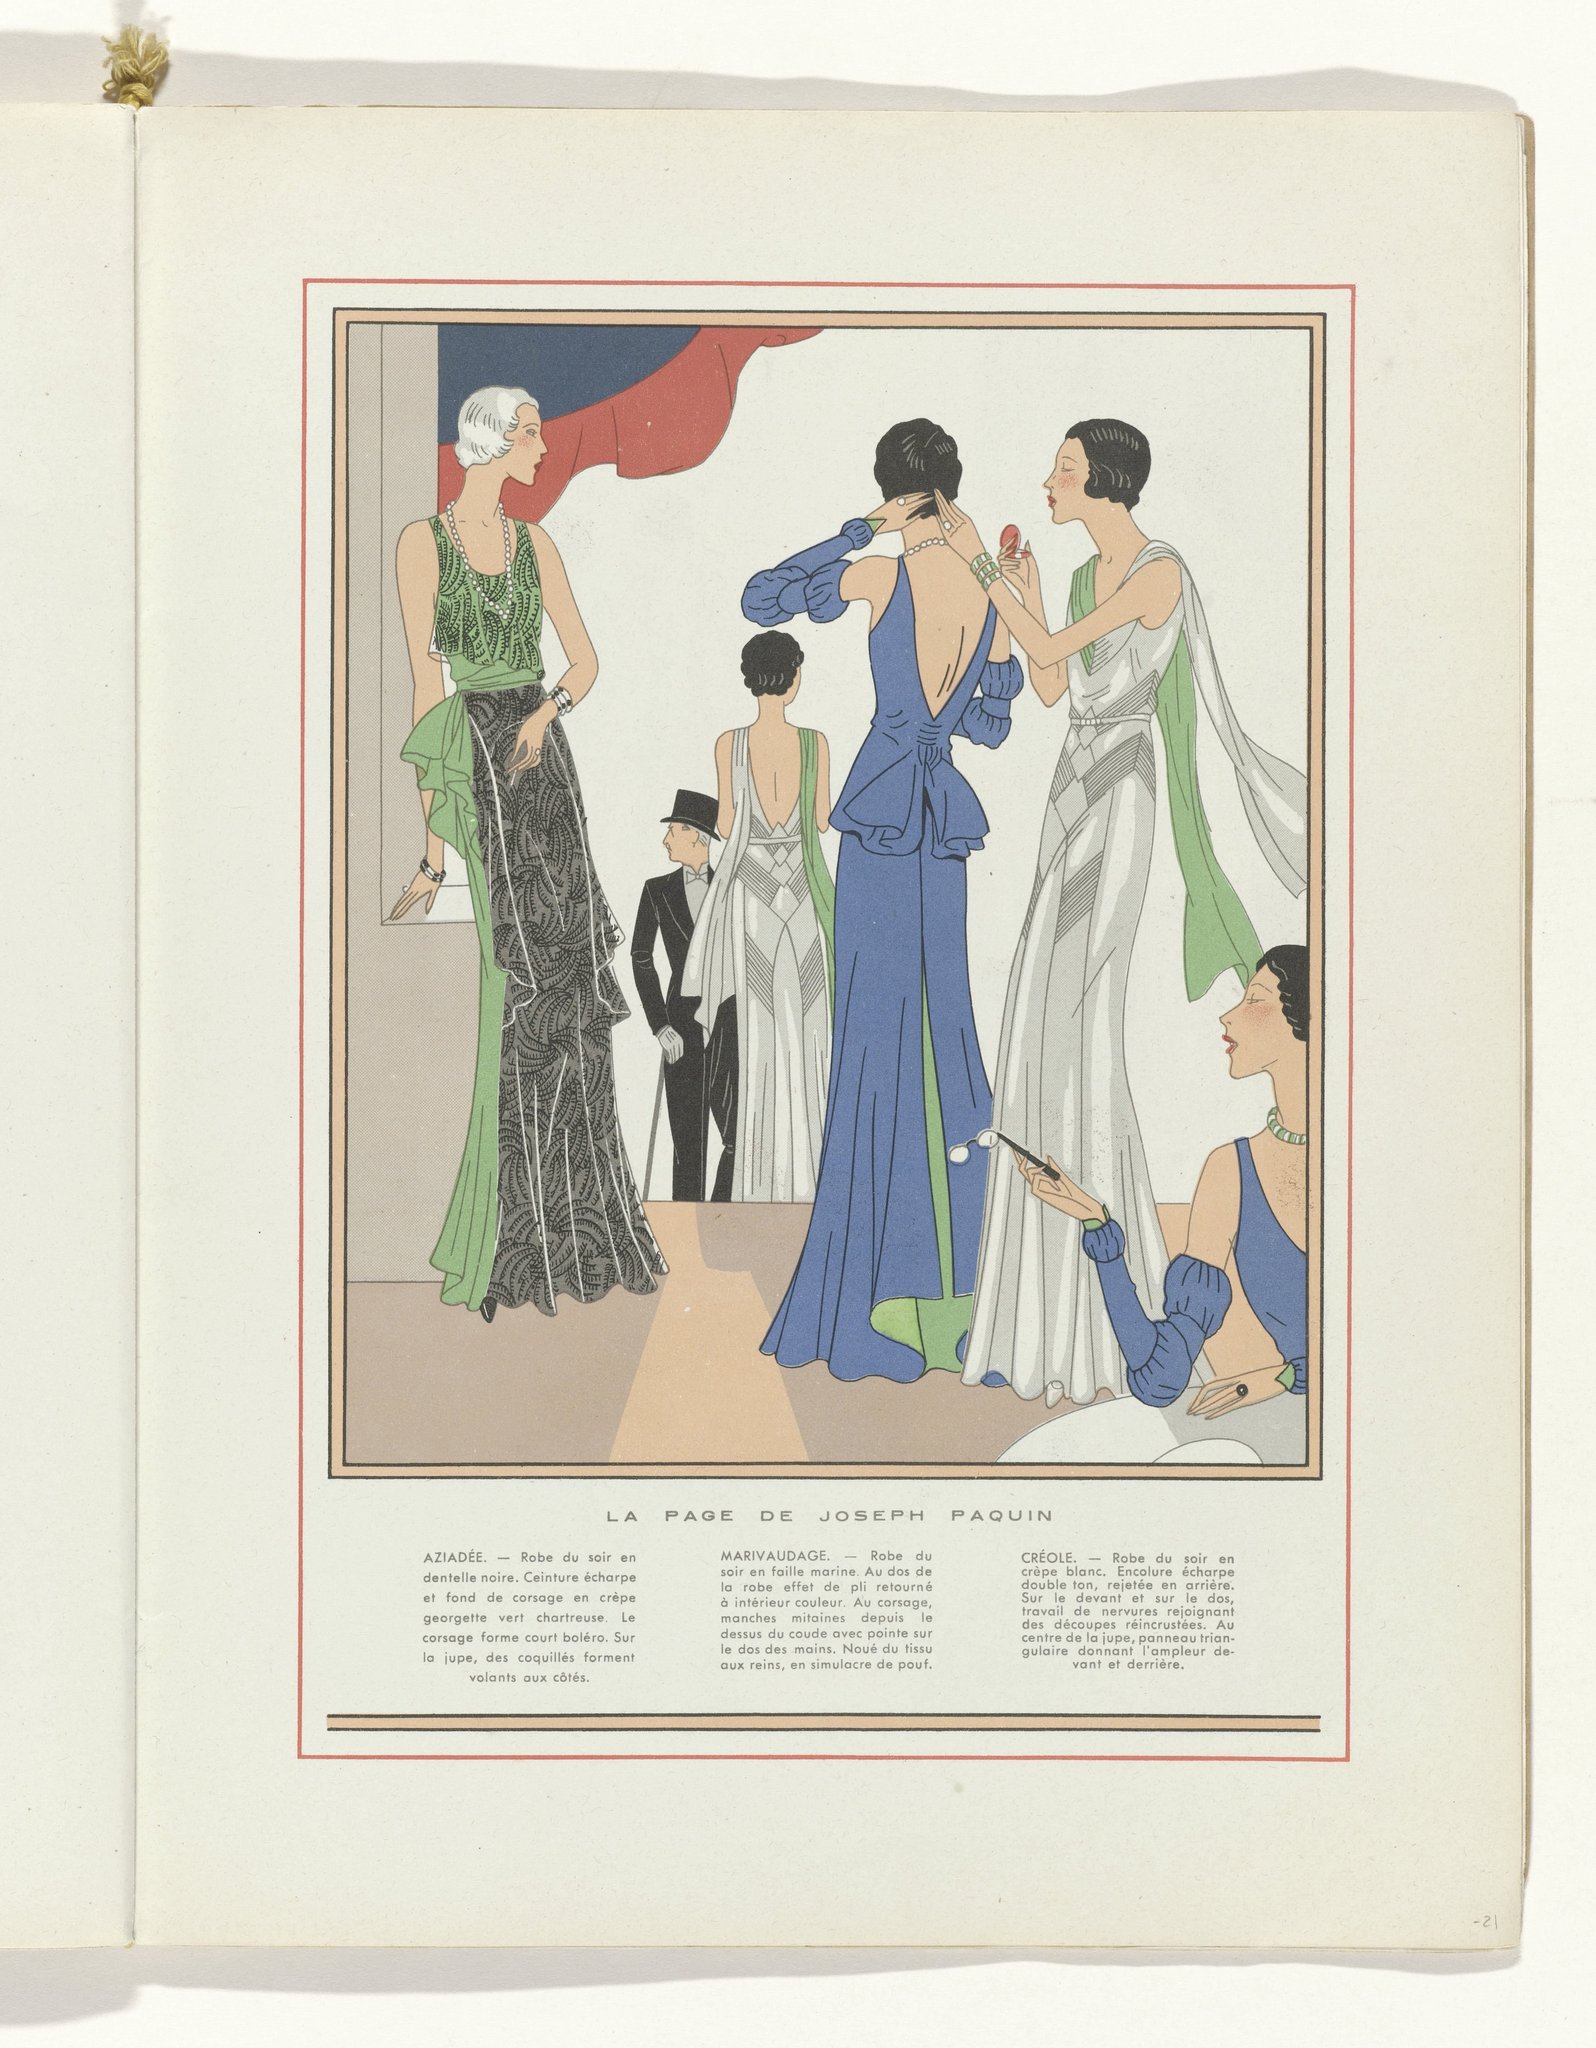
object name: fashion print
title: Art - Goût - Beauté, Feuillets de l' élégance féminine, Mars 1932, No. 139, 12e Année, p. 21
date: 1932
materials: paper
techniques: printing, lithograph, photography, pochoir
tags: dress, gown: evening dress (+ women's clothes), fashion plates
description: Avondjaponnen van Paquin. Pagina uit het modetijdschrift Art-Goût-Beauté (1920-1933).